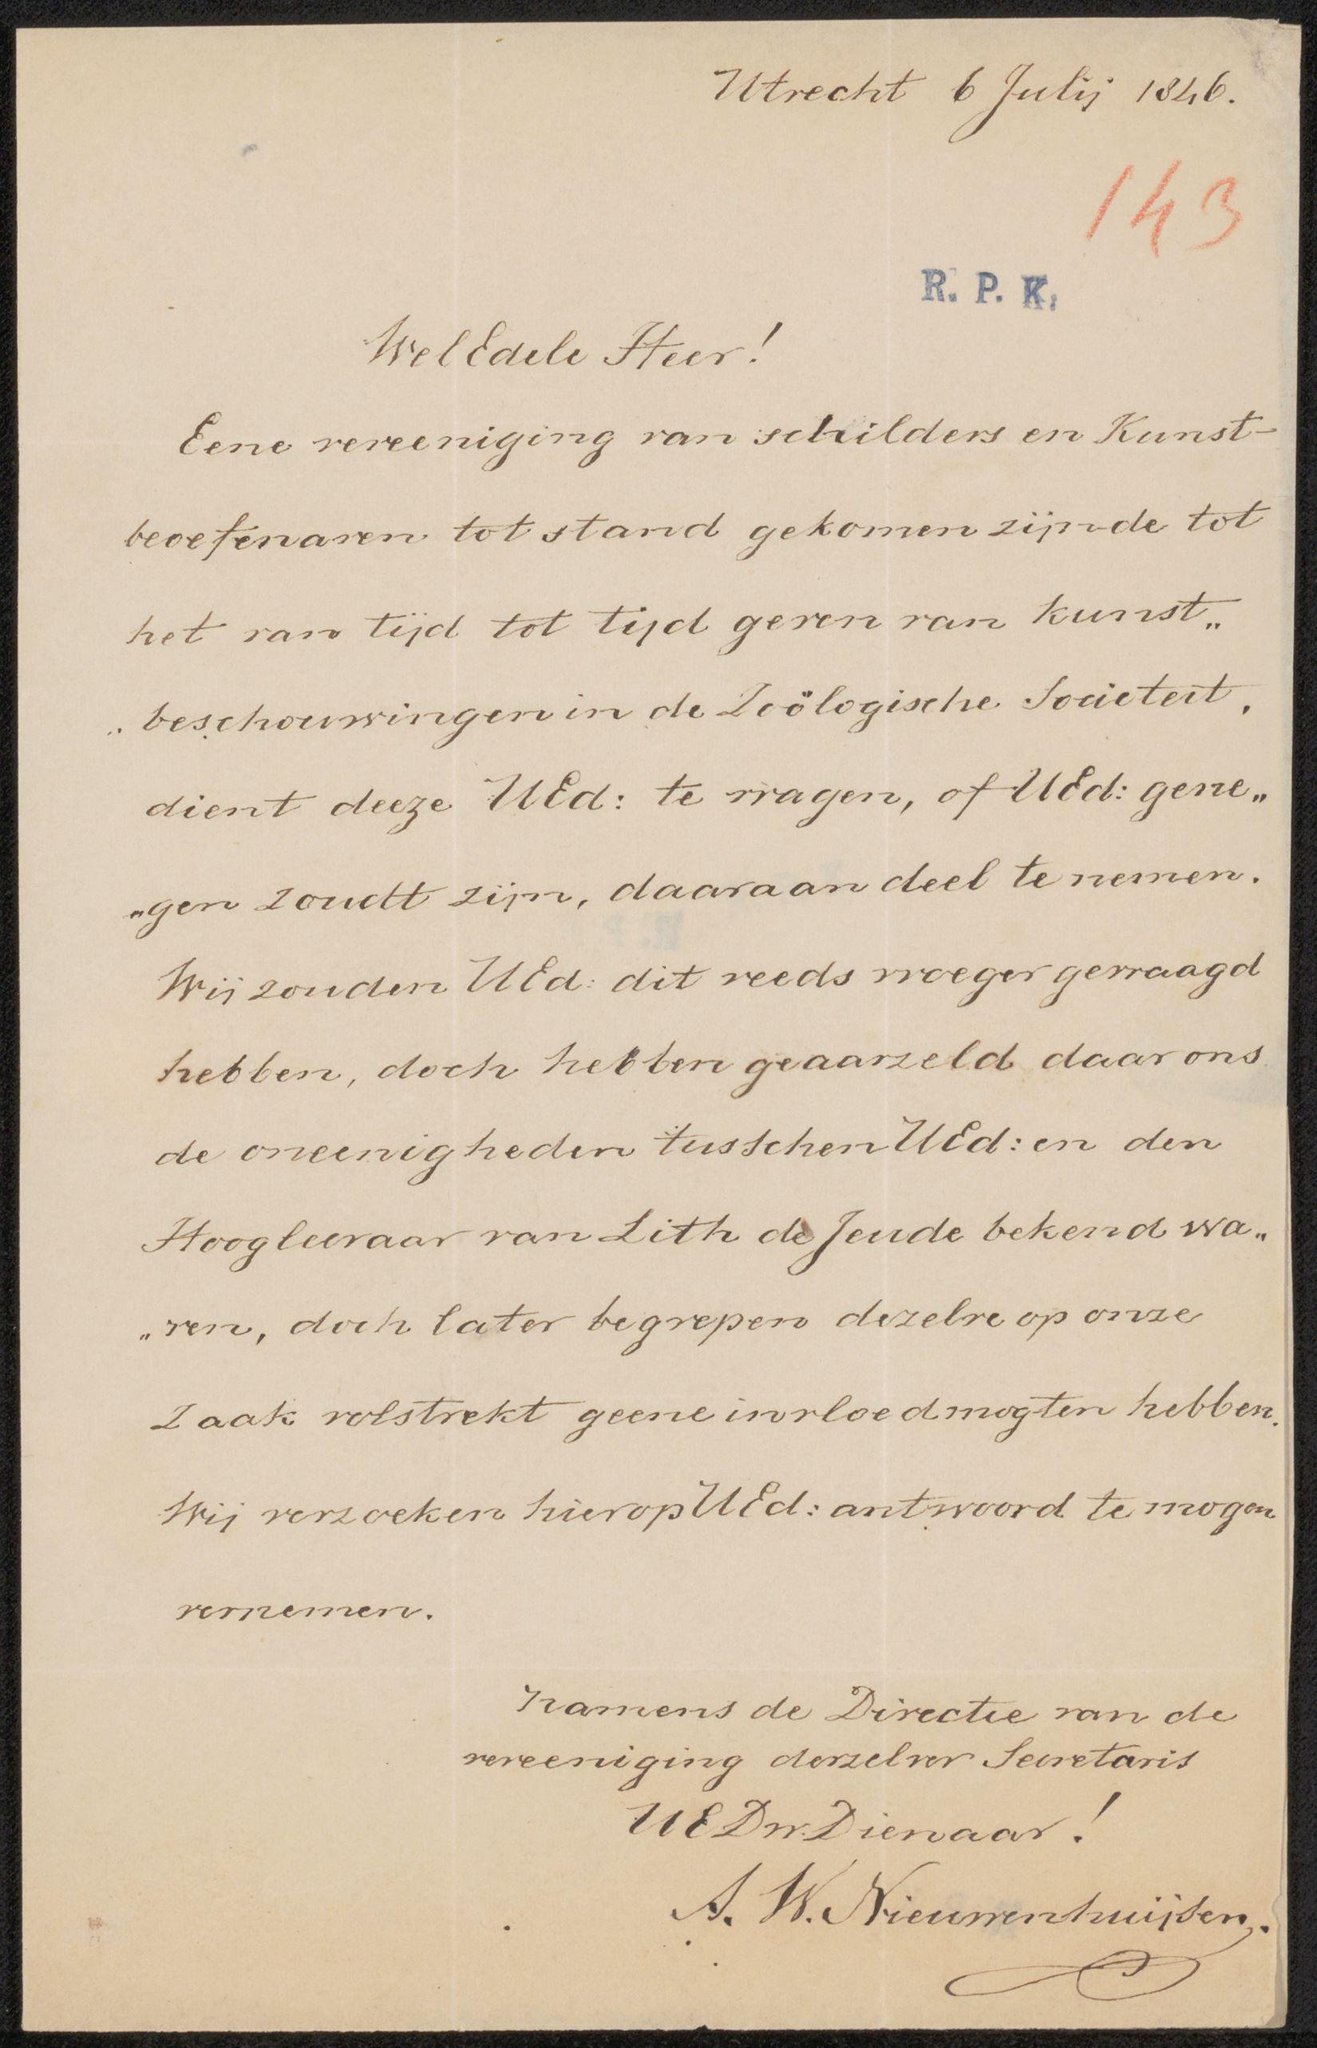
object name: letter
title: Brief aan Christiaan Kramm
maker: adrianus wilhelmus nieuwenhuyzen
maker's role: draughtsman, print maker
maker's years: 1814-1894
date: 1846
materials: ink, paper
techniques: pen, writing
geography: utrecht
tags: utrecht, draughtsman, christiaan kramm, criticizing and discussing art, art criticism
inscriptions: collector's mark: Lugt 2233